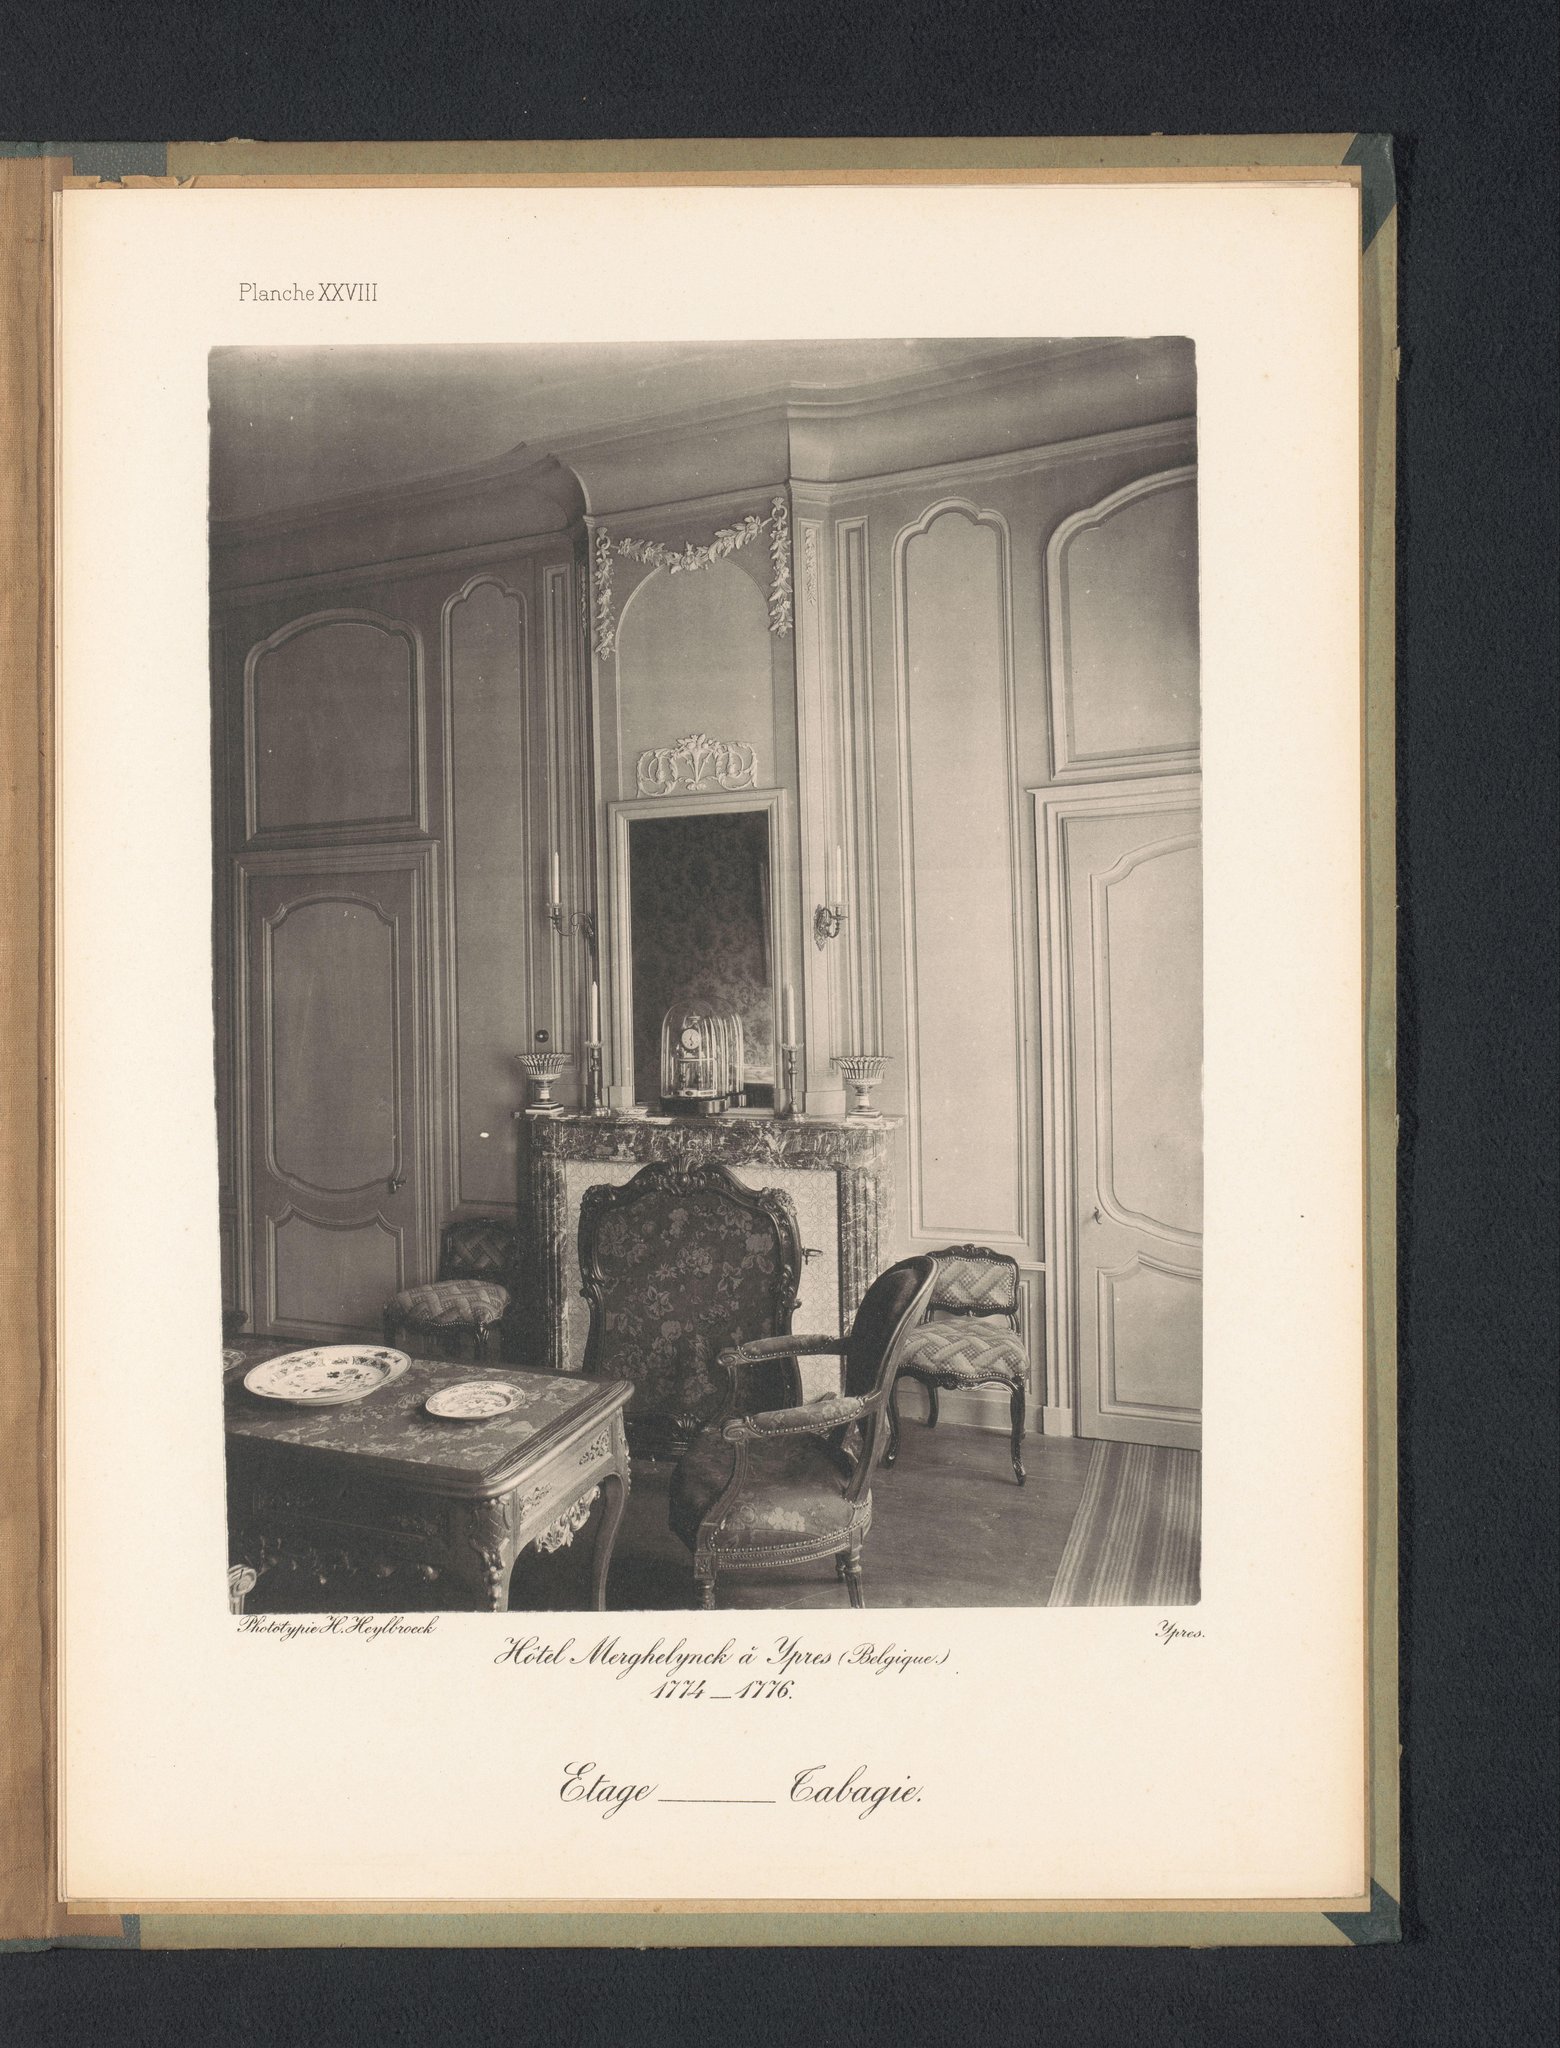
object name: photomechanical print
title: Etage - Cabagie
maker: hector heylbroeck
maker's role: fotograaf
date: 1889-1894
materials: paper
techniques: photograph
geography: ieper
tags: interior of the house, hotel, hostelry, inn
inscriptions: number: ‘Planche XXVIII’, inscription: ‘Ypres.’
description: Deze prent maakt deel uit van een omslag met 31 prenten en een katern met teksten.